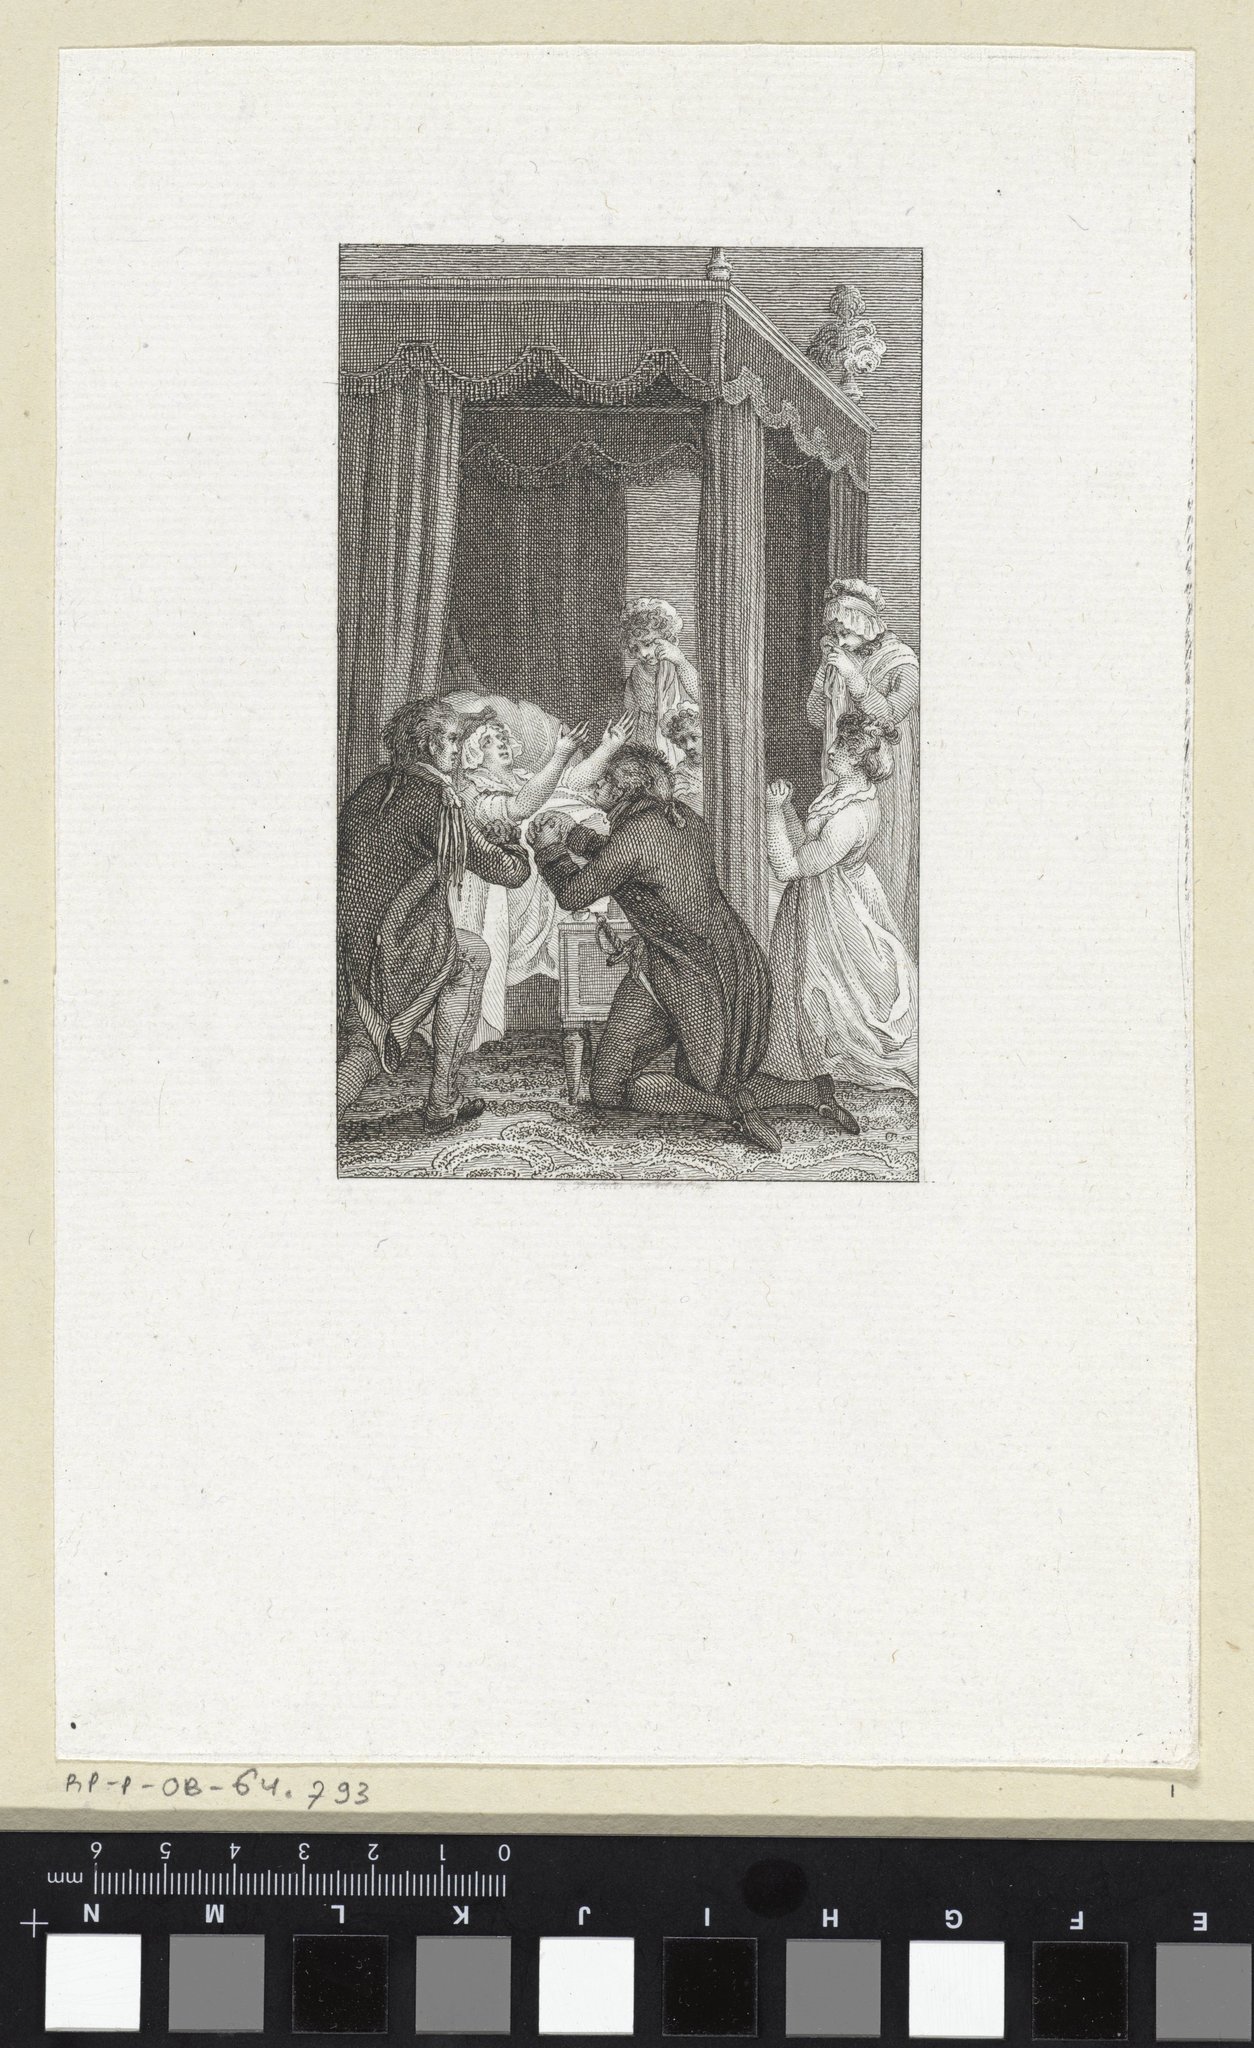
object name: print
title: Biddende en huilende figuren bij het ziekbed van Clarissa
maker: reinier vinkeles (i)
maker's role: draughtsman, print maker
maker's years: 1741-1816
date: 1805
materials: paper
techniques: engraving, etching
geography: amsterdam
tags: weeping, kneeling figure, visiting the sick; sick person together with others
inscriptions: collector's mark: Lugt 240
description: Illustratie uit: Richardson, Samuel. Geschiedenis van Clarissa Harlowe. Deel 8. Amsterdam: Johannes Allart, 1797-1805.